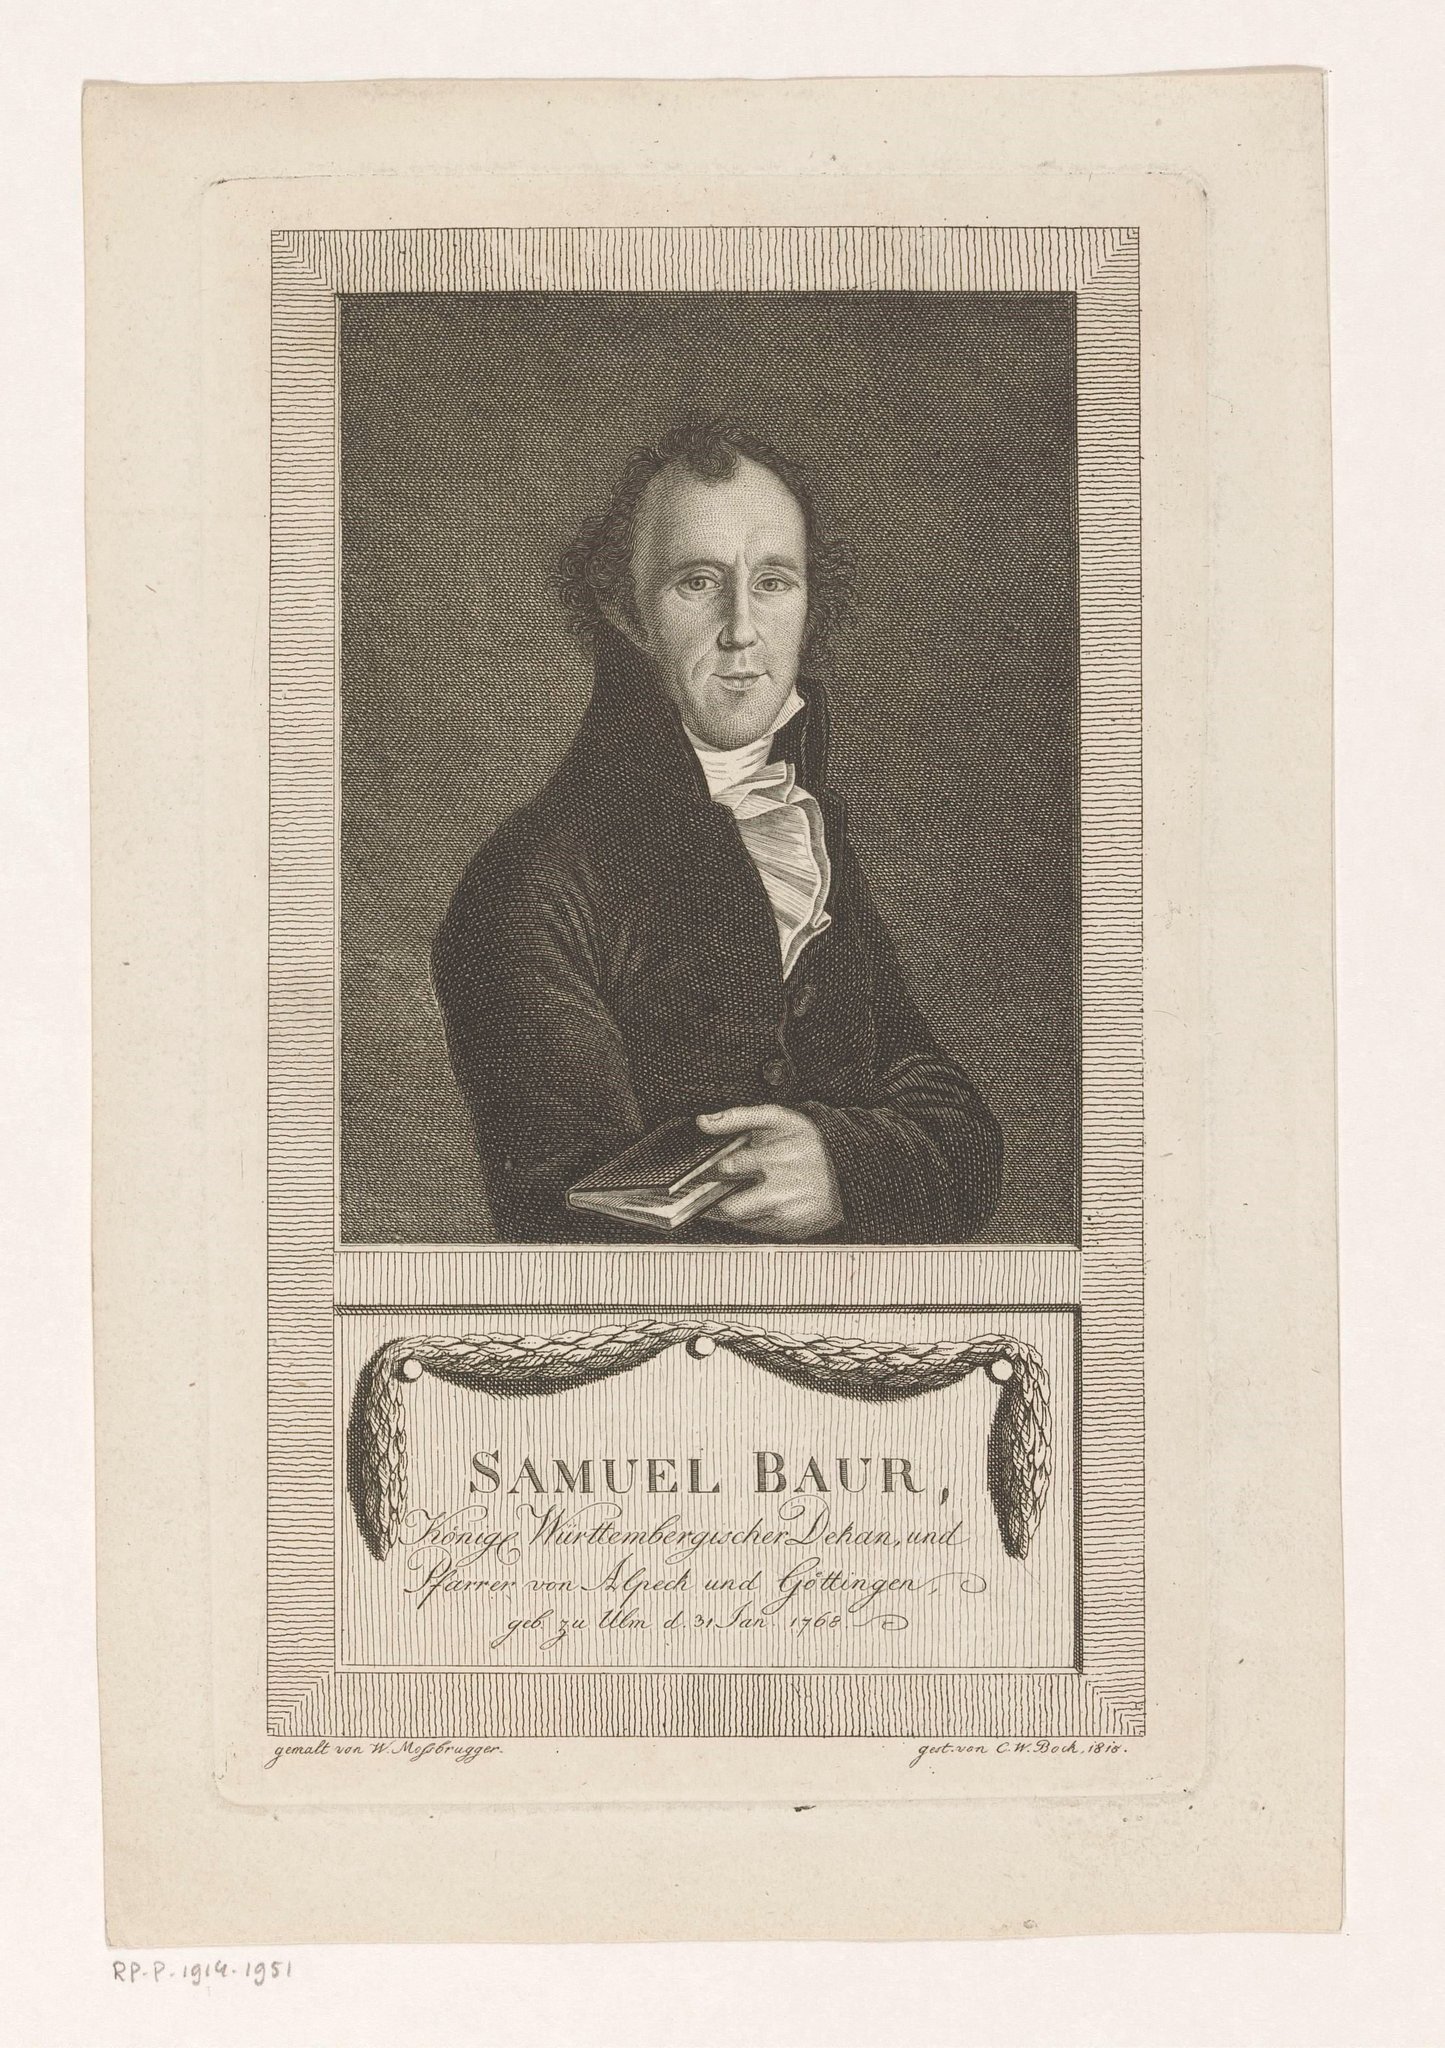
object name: print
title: Portret van Samuel Baur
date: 1815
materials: paper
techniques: engraving, etching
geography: nuremberg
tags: historical persons, book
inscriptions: collector's mark: Lugt 2228